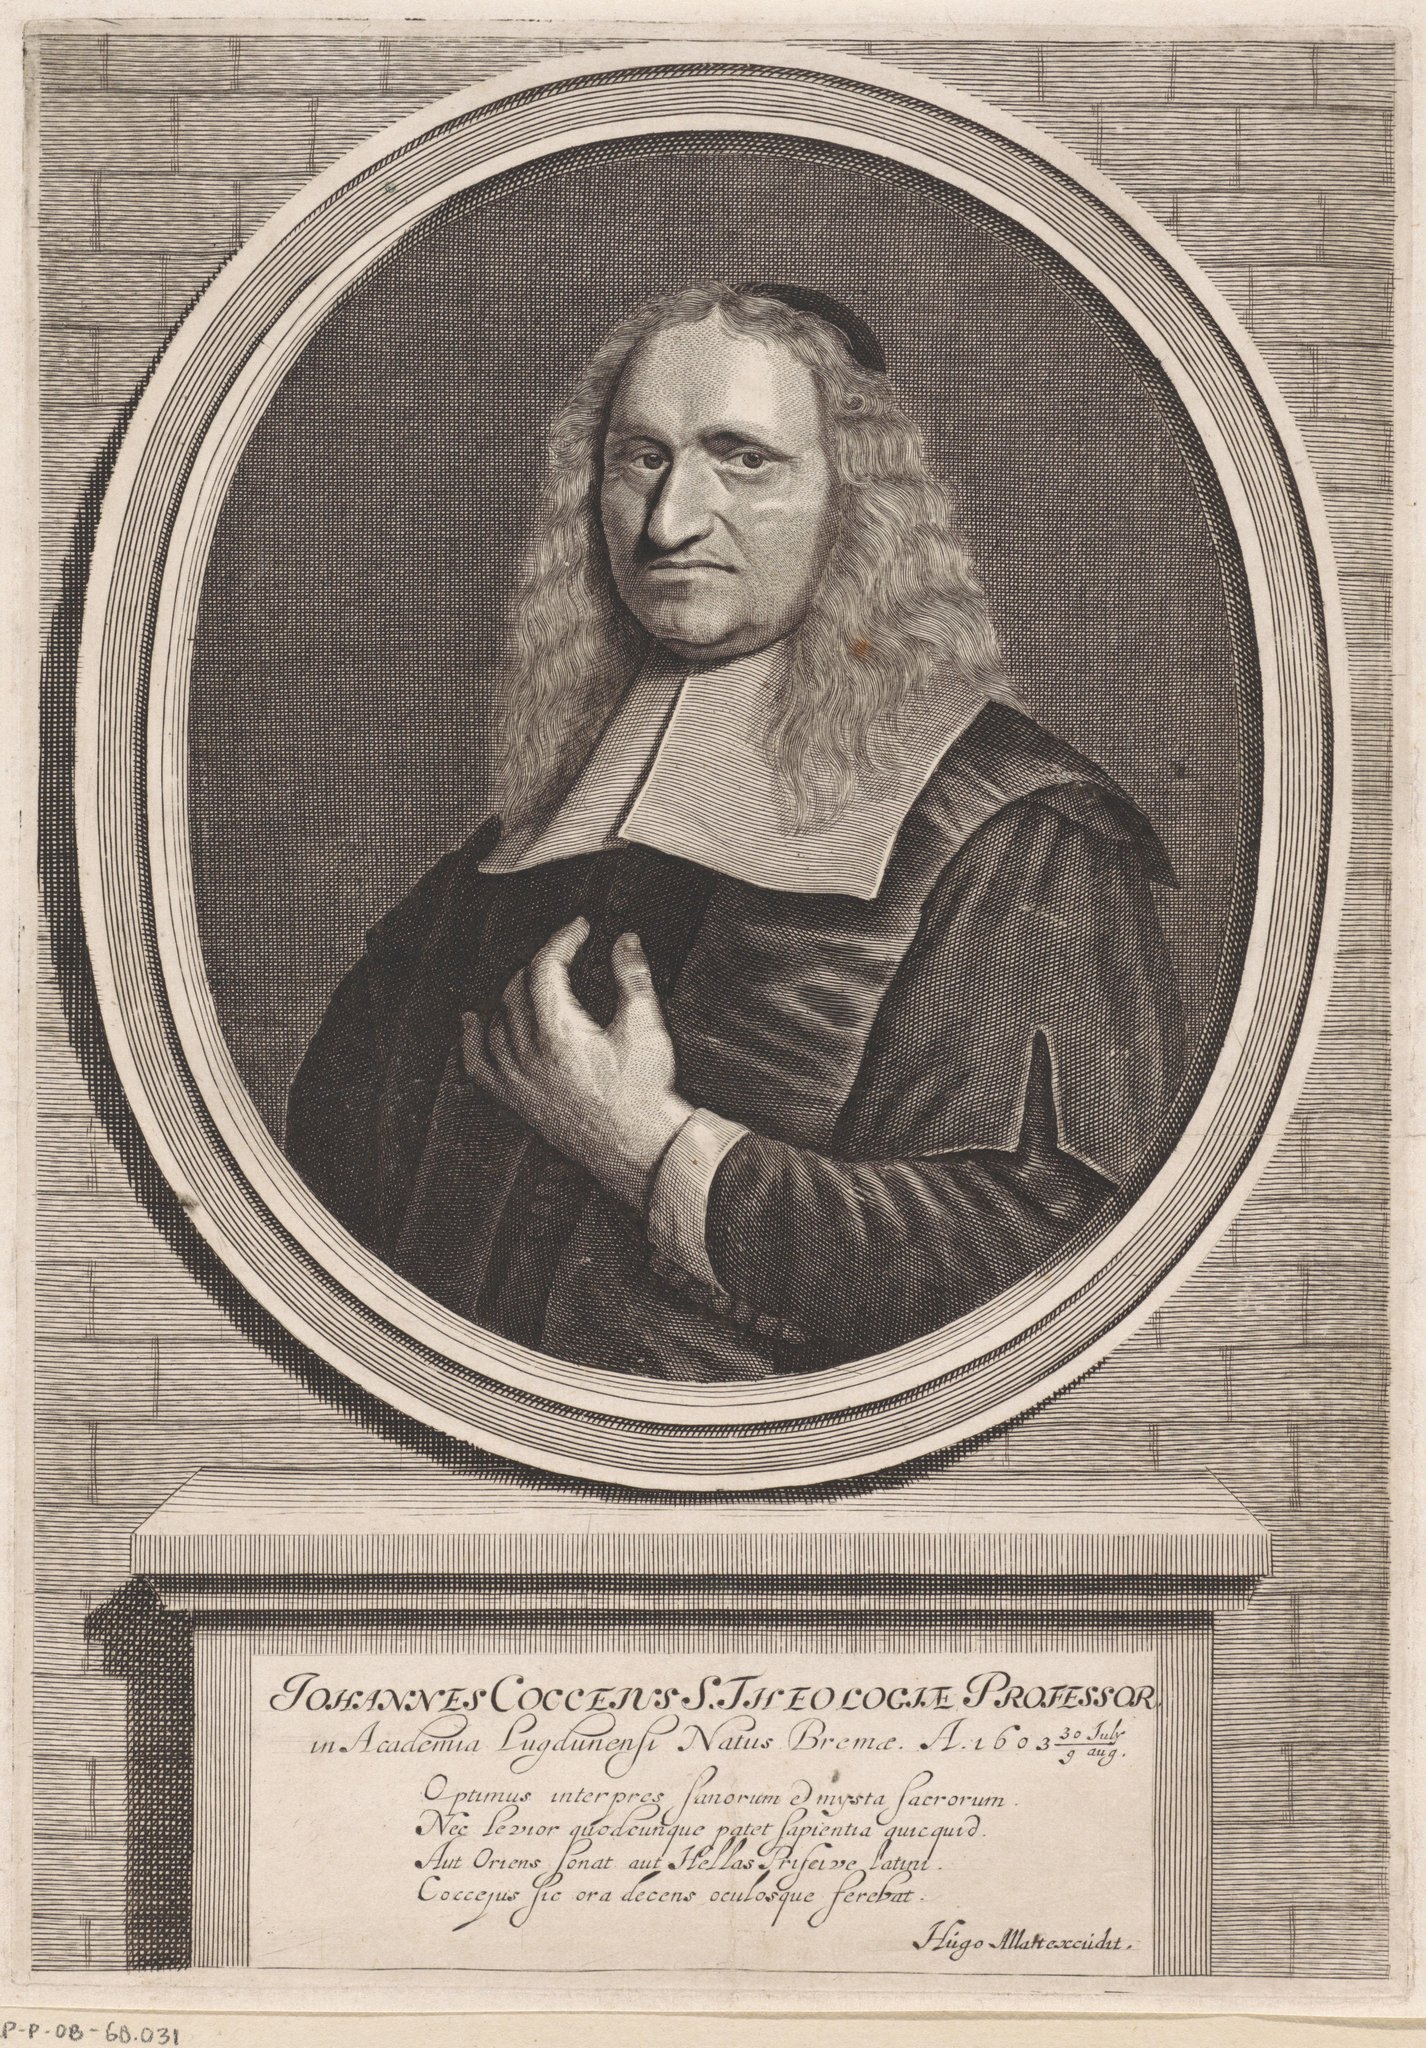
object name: print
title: Portret van Johannes Cocceius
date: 1645-1684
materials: paper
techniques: engraving, etching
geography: low countries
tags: historical persons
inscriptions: collector's mark: Lugt 240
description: Portret van de theoloog Johannes Cocceius in een ovale omlijsting. Onder het portret enkele biografische gegevens en de functie van de geportretteerde. Daaronder een vierregelig onderschrift in het Latijn.